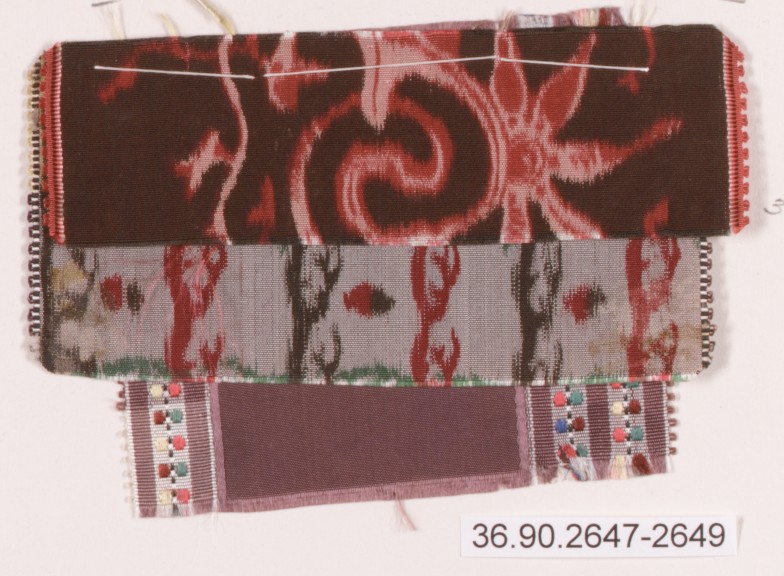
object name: ribbon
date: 1801-1900